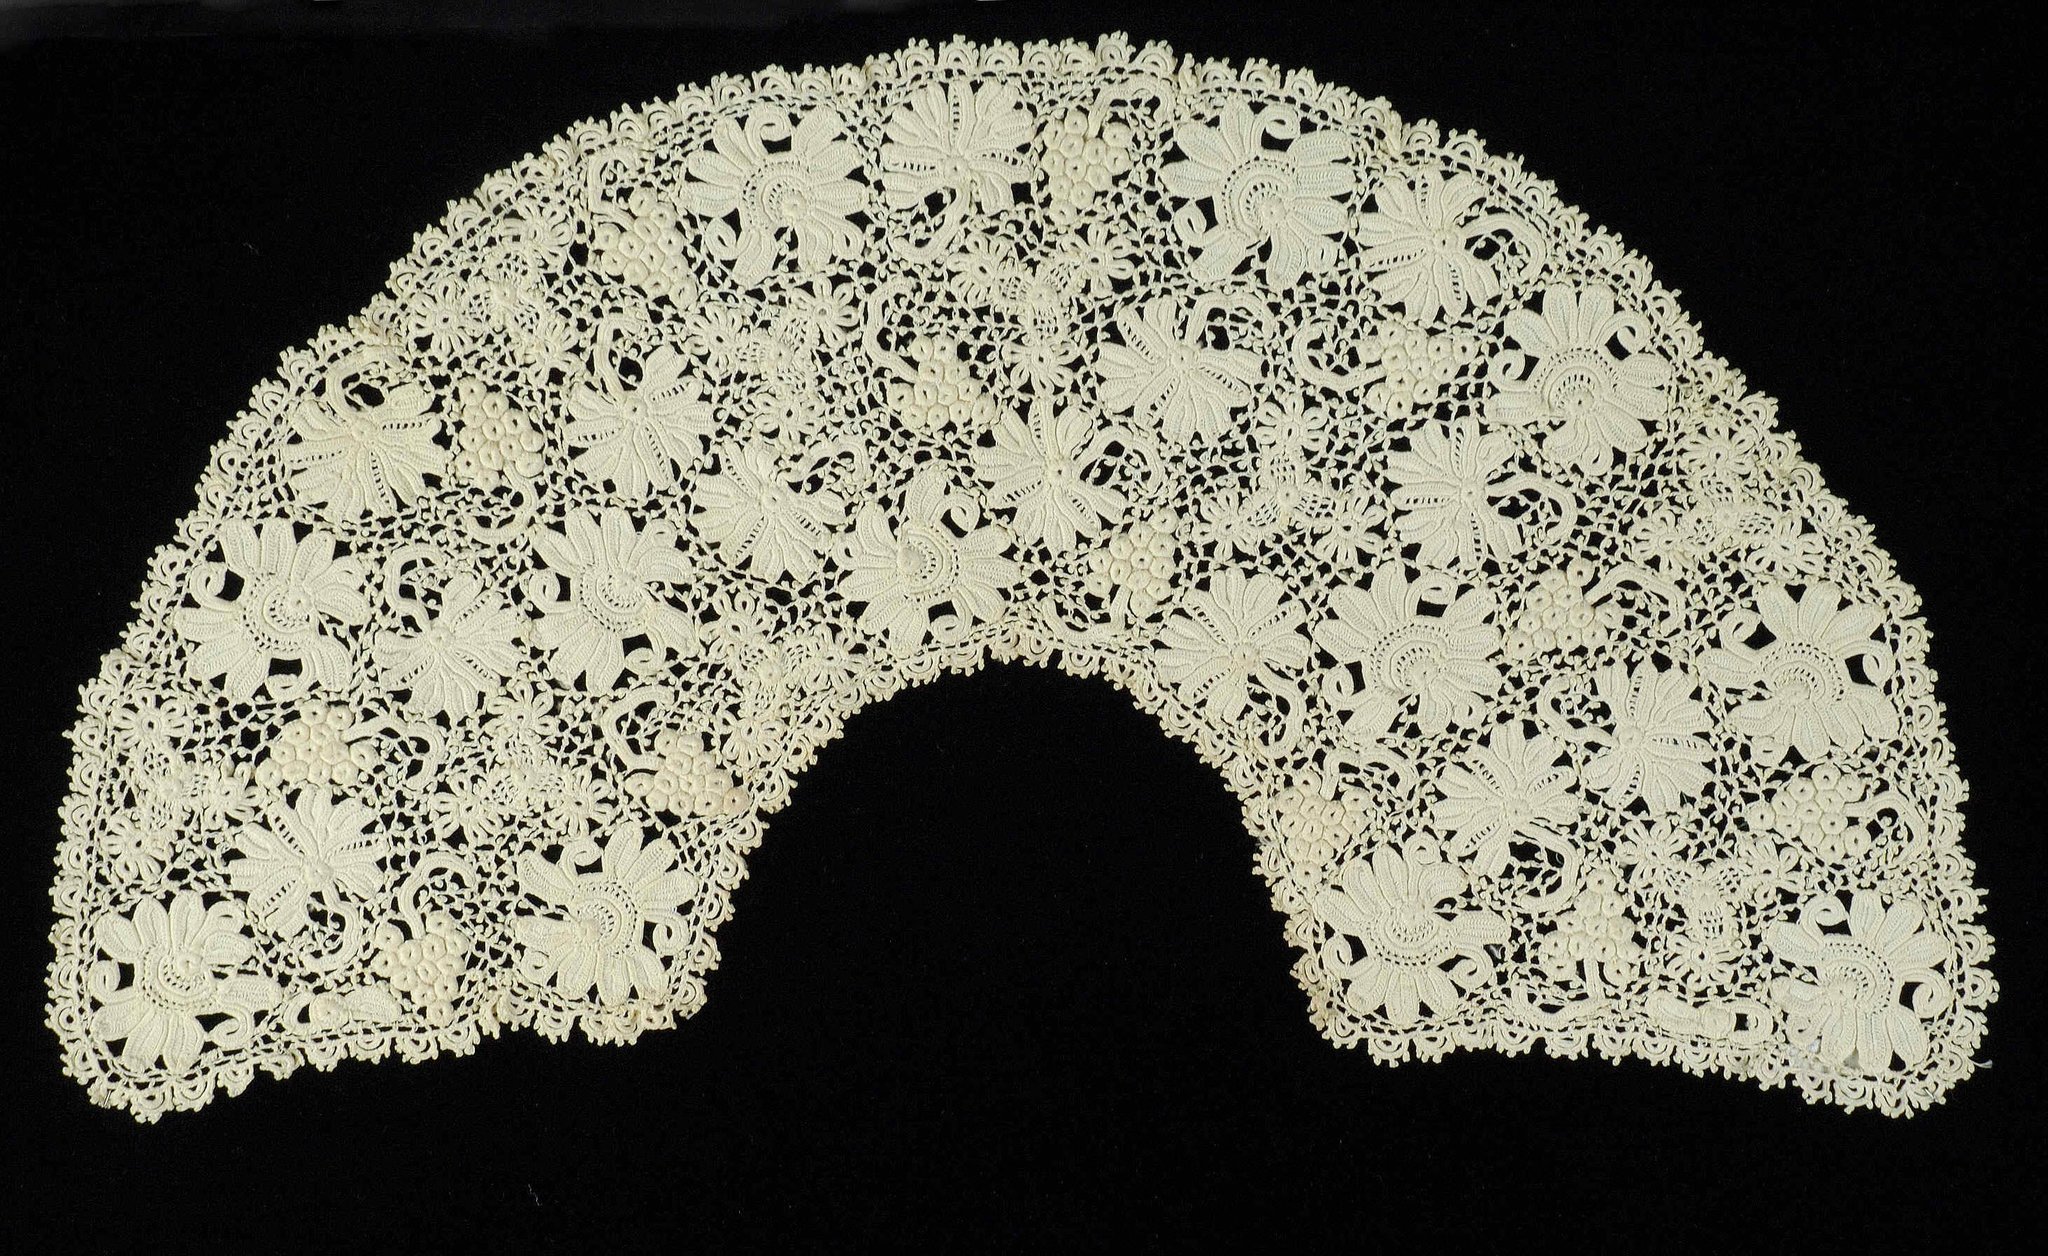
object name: collar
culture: irish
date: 1890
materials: cotton